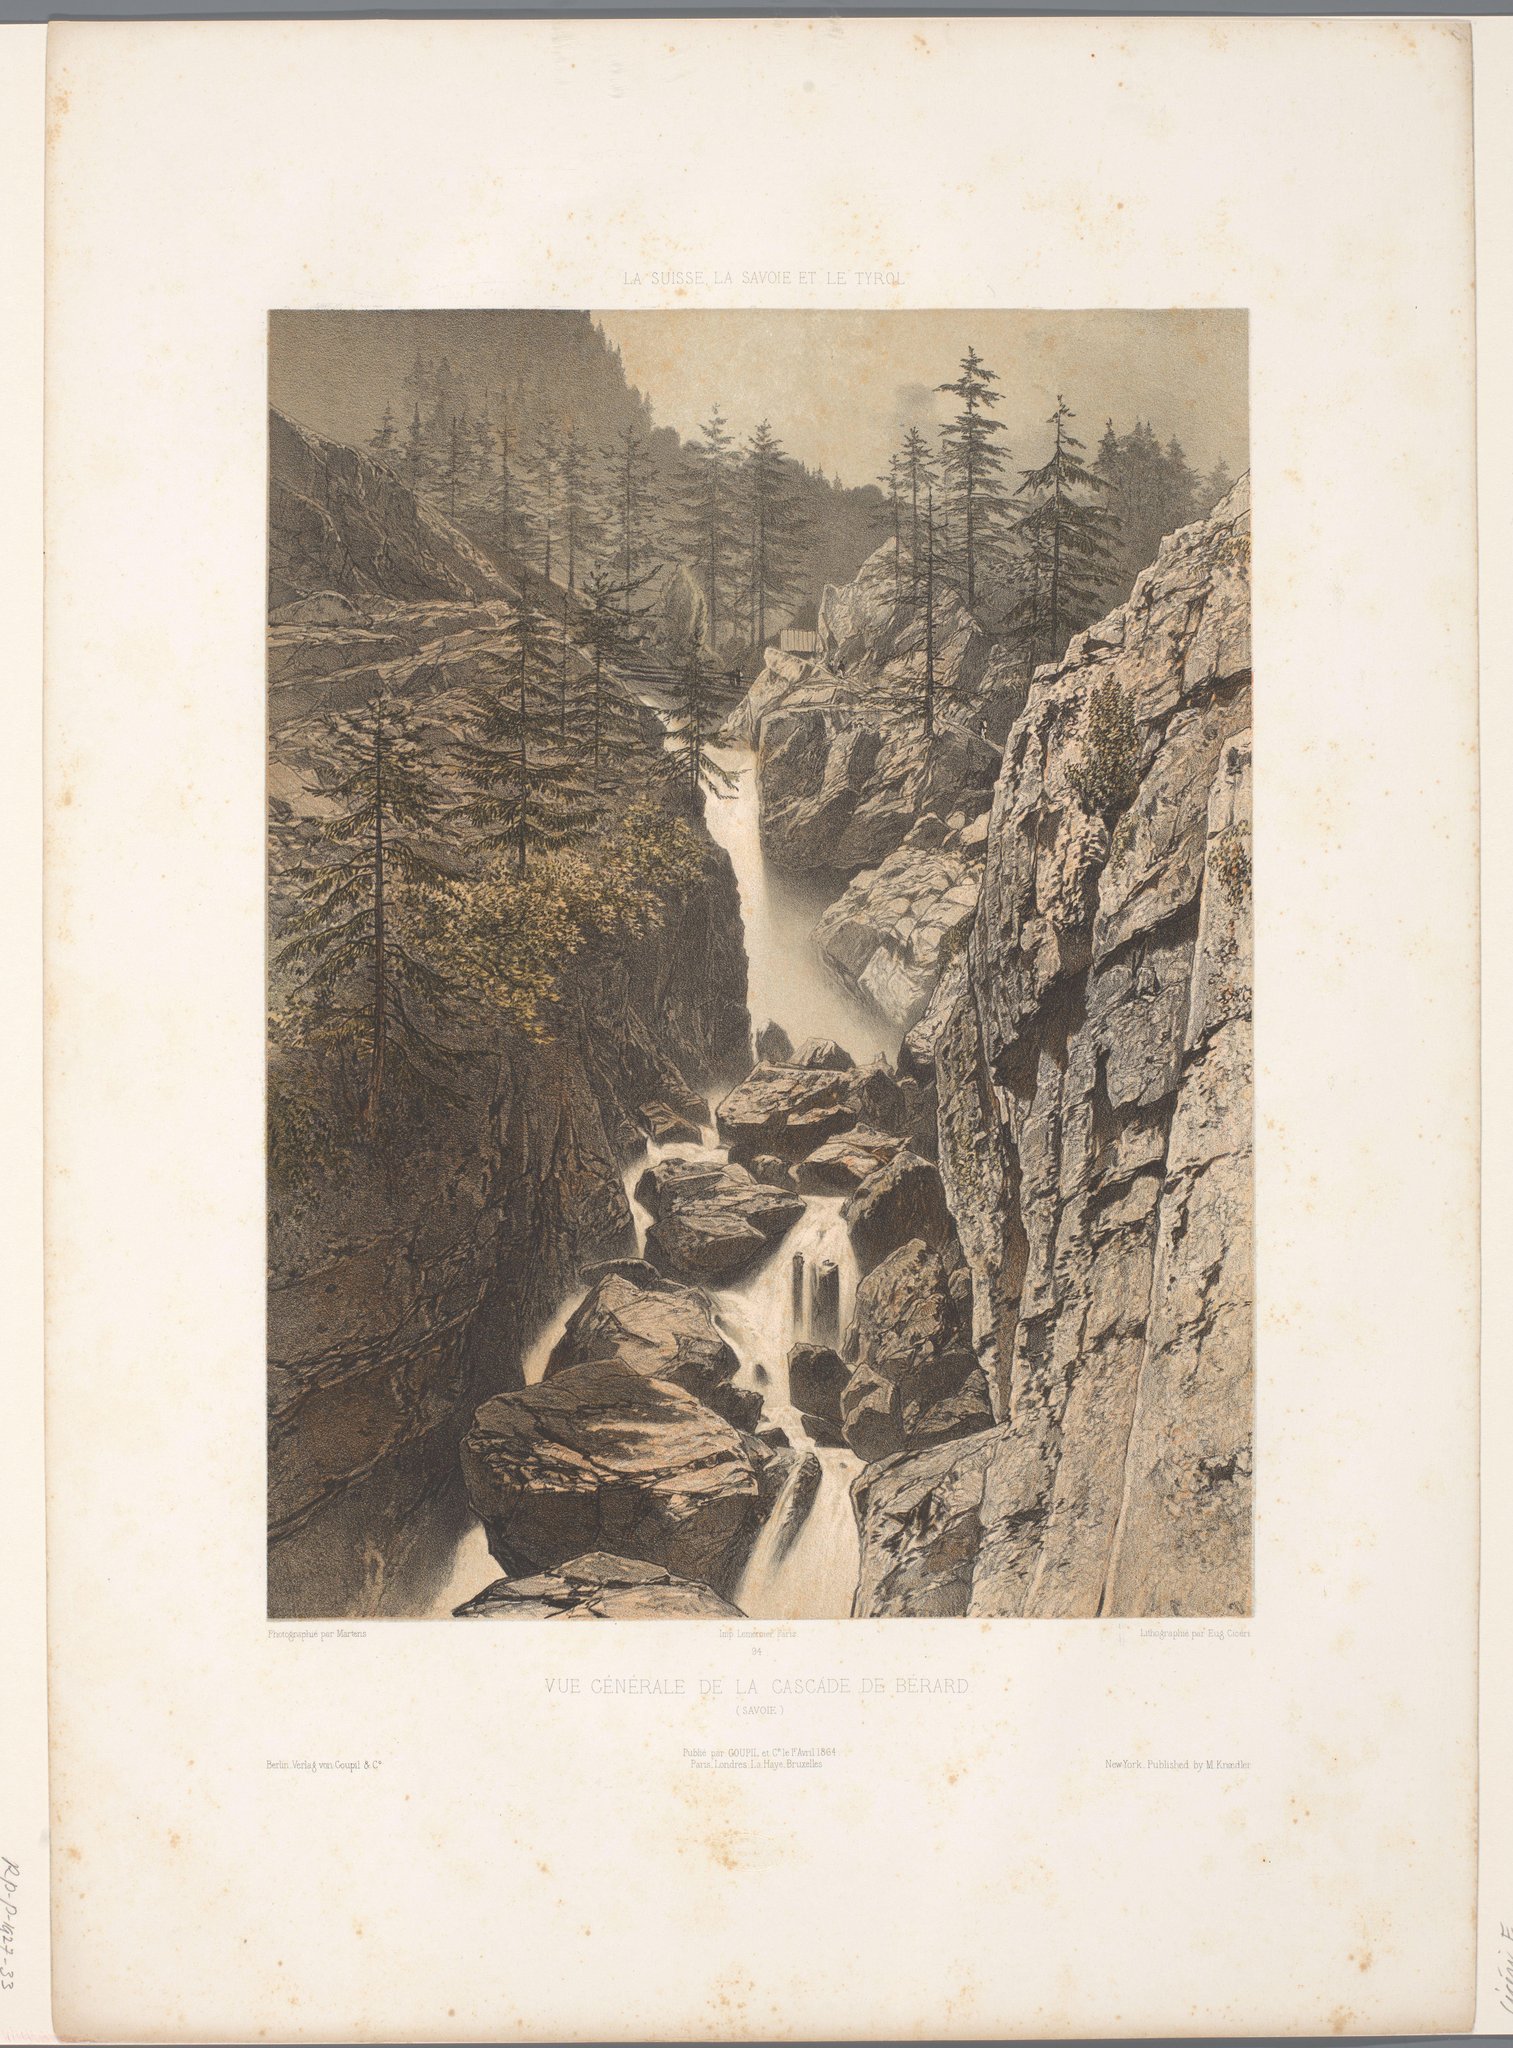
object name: print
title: Gezichten in Zwitserland, Savoye en Tirol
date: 1859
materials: paper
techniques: lithograph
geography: paris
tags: waterfall (+ landscape with figures, staffage), ravine, chasm, abyss, canyon (+ landscape with figures, staffage)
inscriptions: check stamp: Lugt 1090